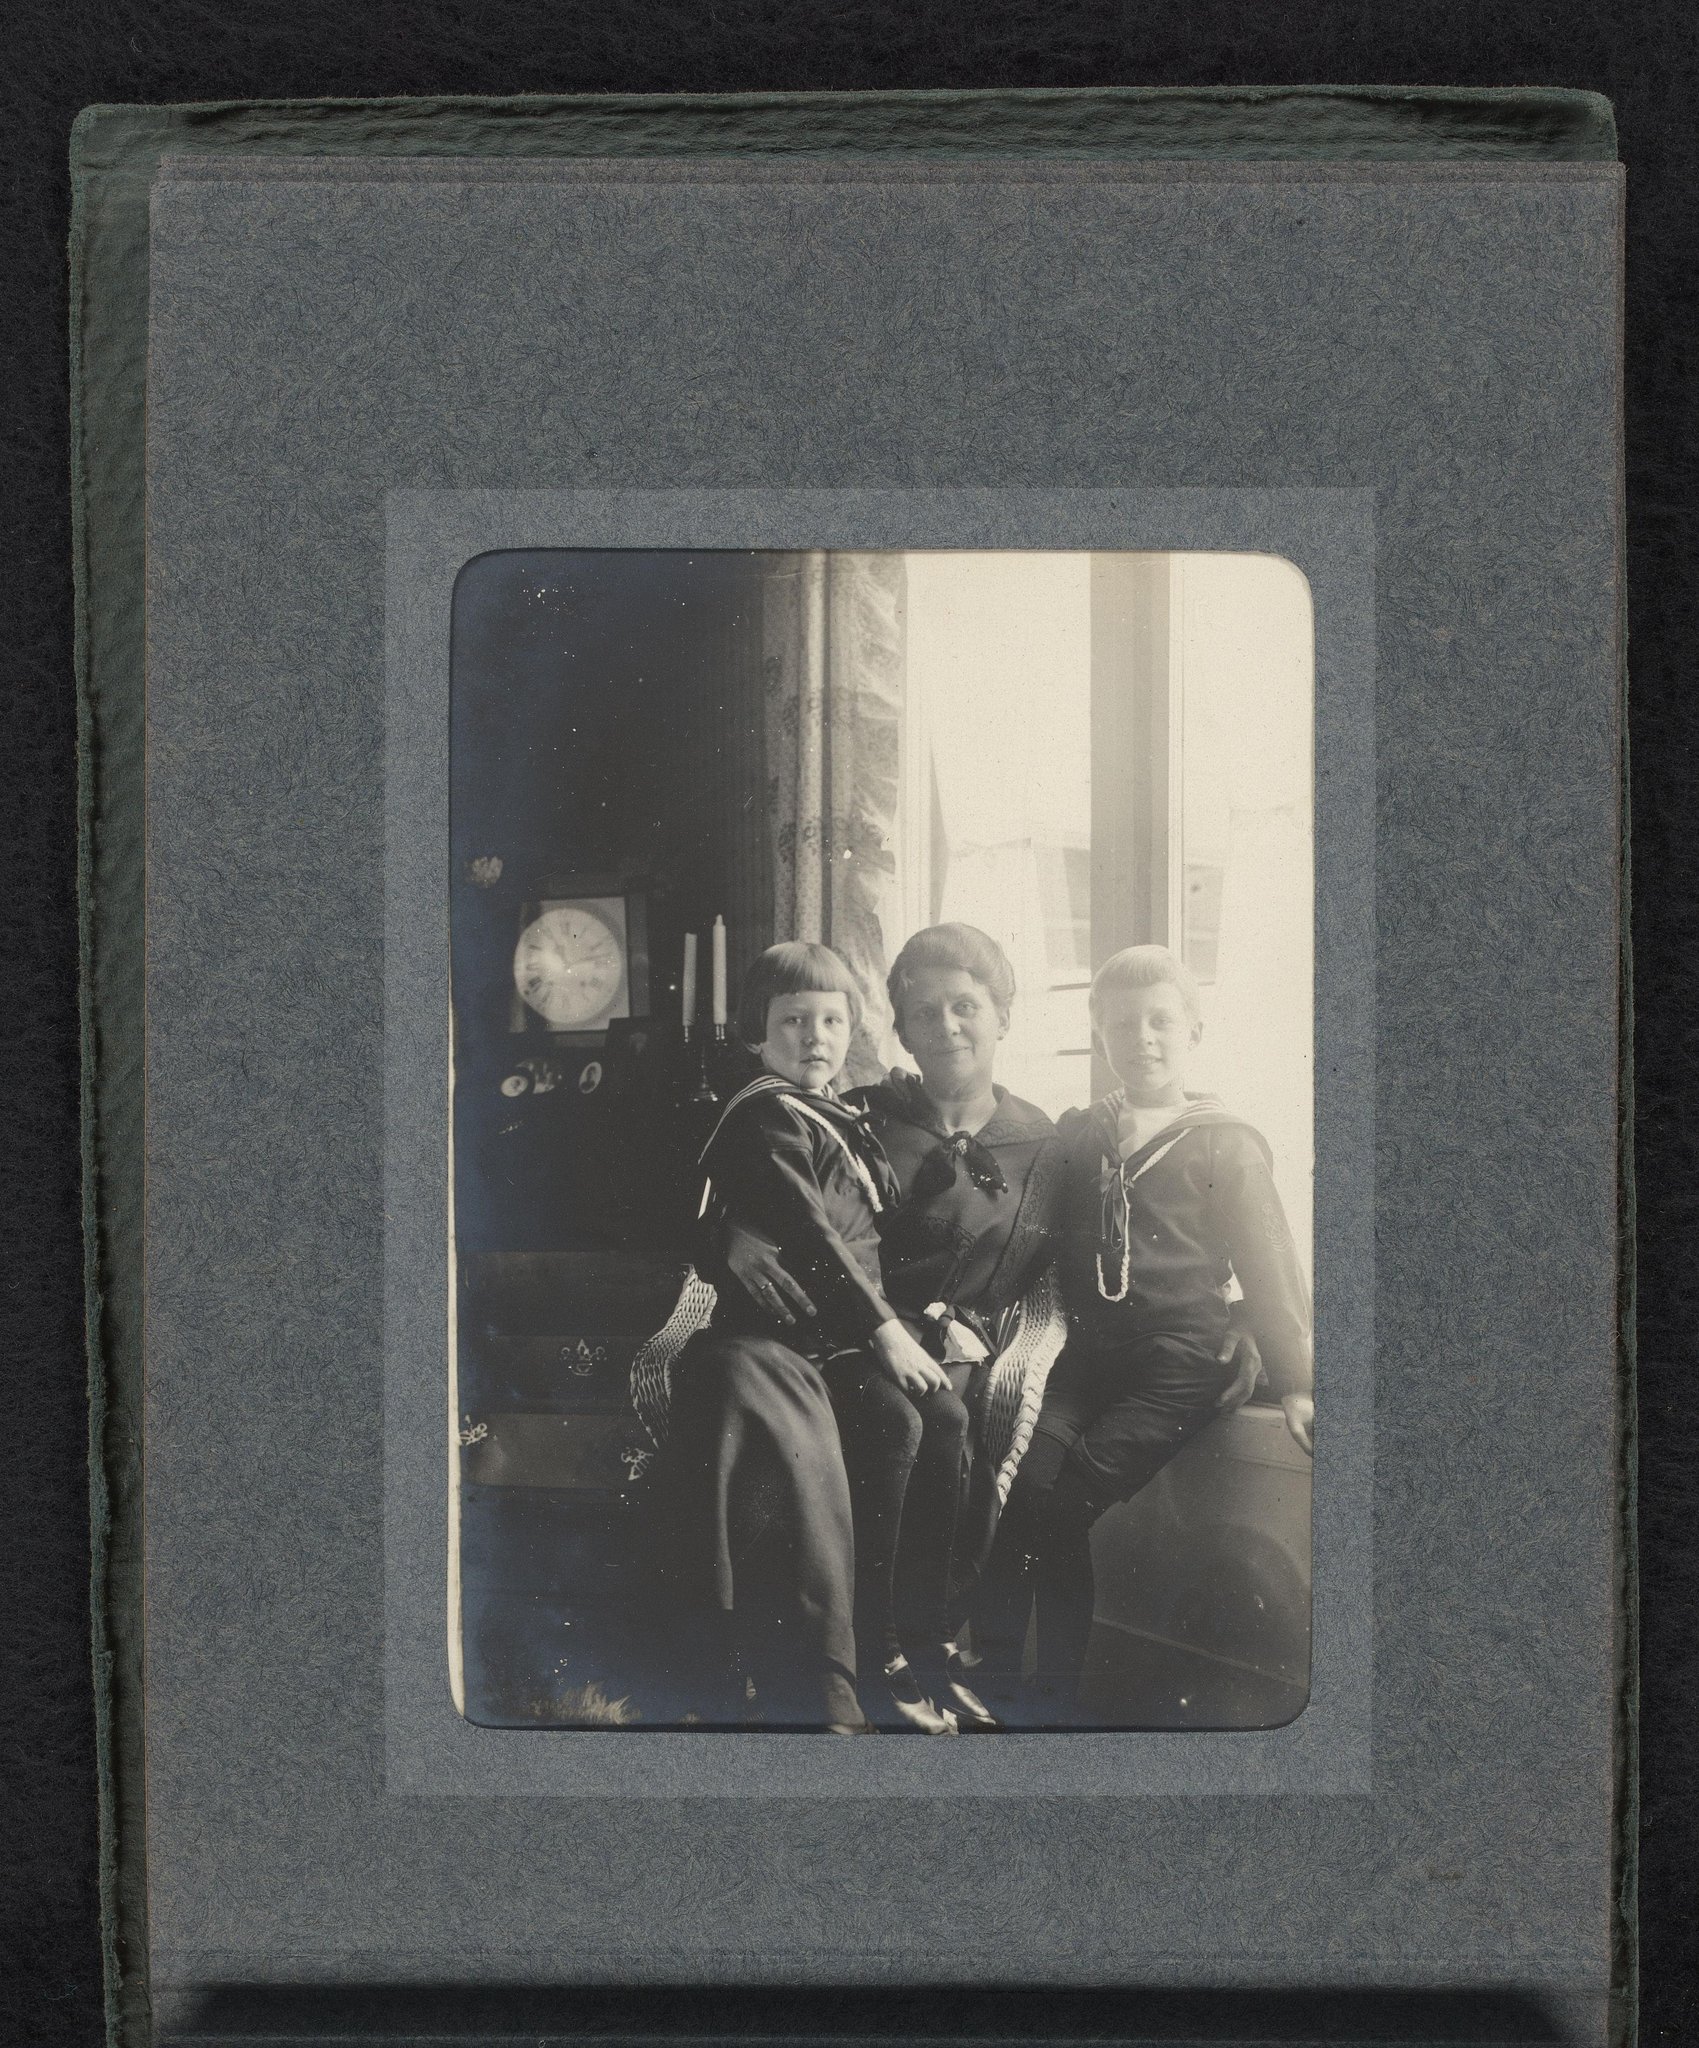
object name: photograph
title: Caroline van den Berg met haar twee zoons, Carel en Frank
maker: hendrik herman van den berg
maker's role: amateurfotograaf, jurist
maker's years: 1875-1944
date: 1918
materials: paper, cardboard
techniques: gelatin silver print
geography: amsterdam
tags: the hague, caroline louise van den berg-van den berg, carel frederik van den berg (cay), frank willem van den berg (1912-1998), mother and son(s) (family group)